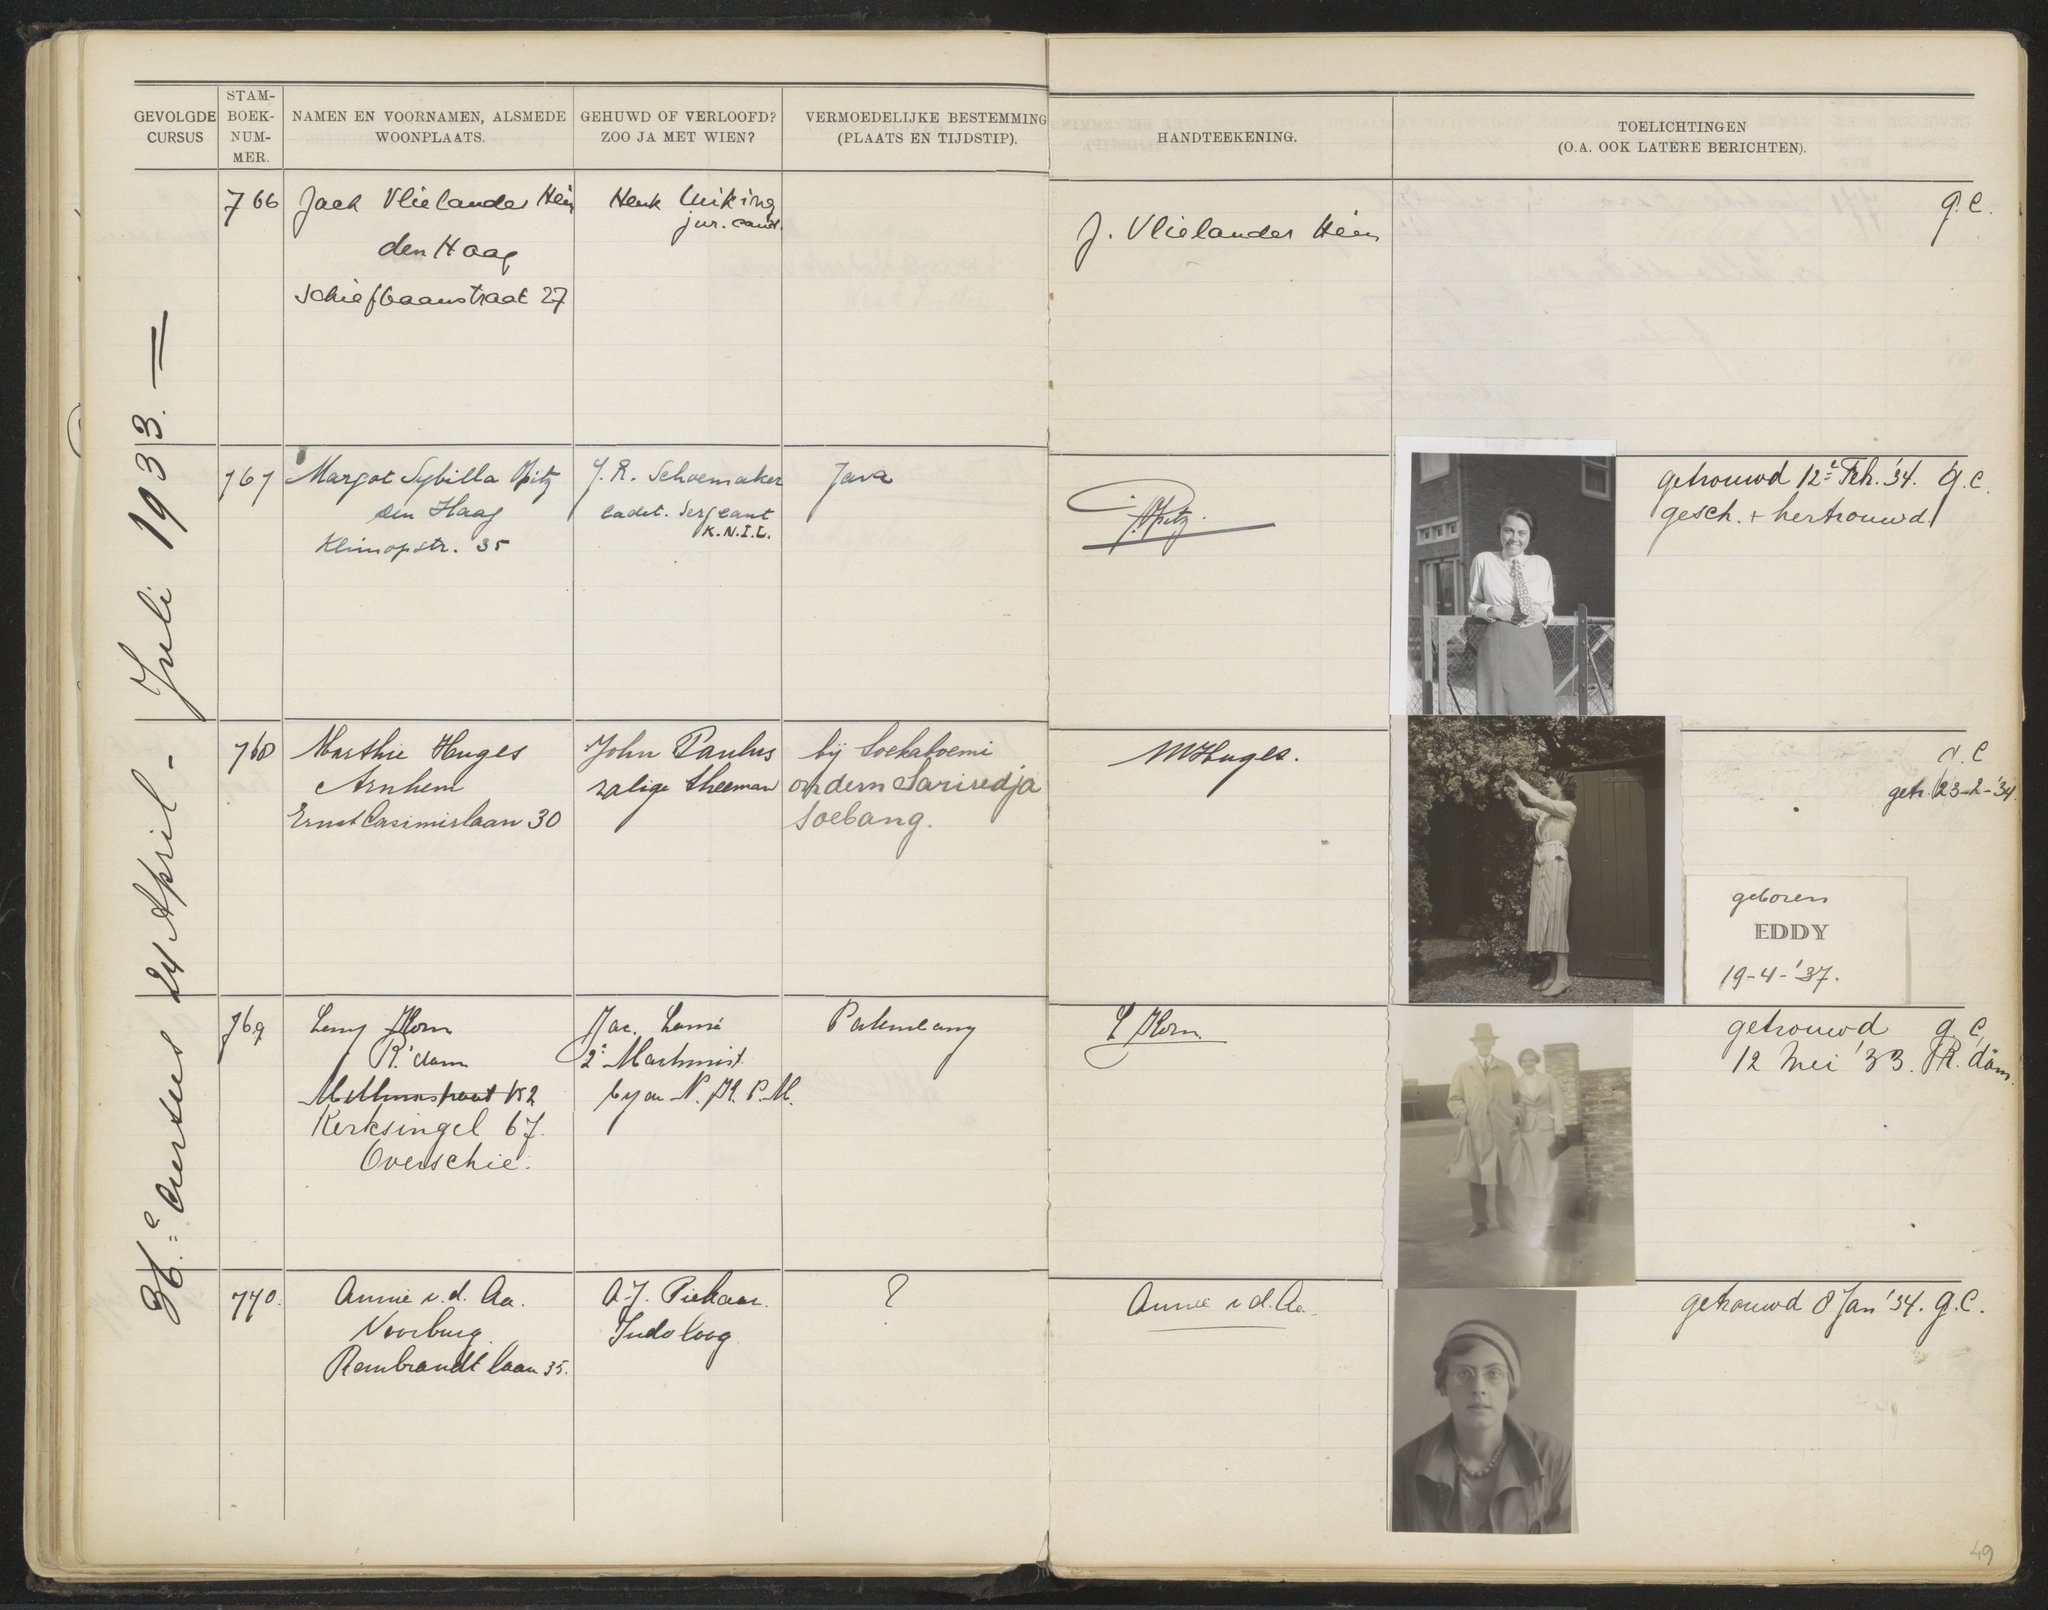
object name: photograph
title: Blad 49 uit Stamboek van de leerlingen der Koloniale School voor Meisjes en Vrouwen te 's-Gravenhage deel II (1930-1949)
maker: Anonymous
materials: paper, photographic support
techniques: photography, printing, writing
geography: the hague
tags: further education (+ pupil), further education, the hague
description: Twee pagina's met gegevens van de deelnemers aan de 36e driemaandelijkse cursus van 24 april tot juli 1933, stamboeknummers 766 tot en met 770. Onderdeel van Stamboek van de leerlingen der Koloniale School voor Meisjes en Vrouwen te 's-Gravenhage deel II (1930-1949).